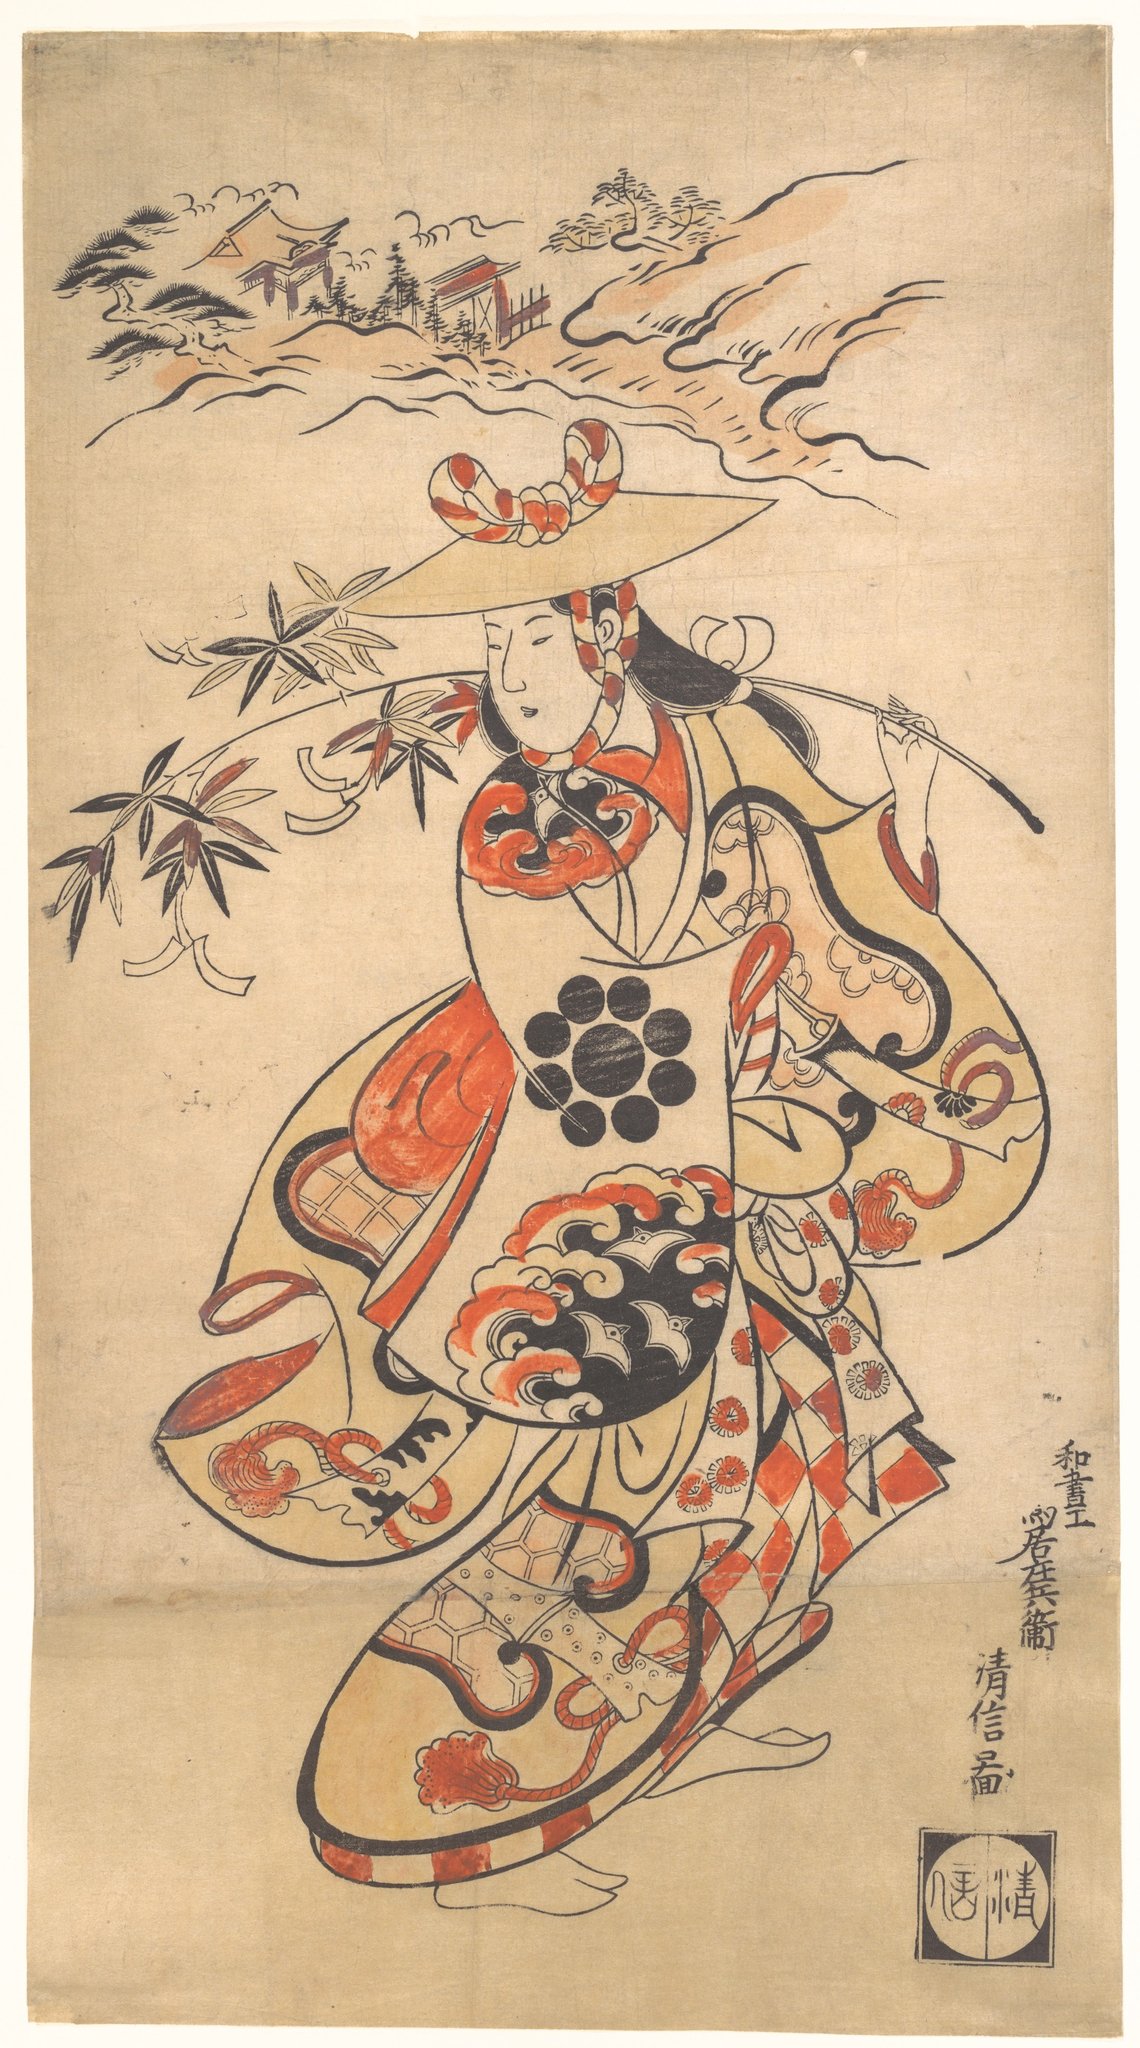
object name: print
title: Actor Sawamura Kodenji as a Woman at the Time of the Tanabata Festival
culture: japanese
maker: torii kiyonobu i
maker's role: artist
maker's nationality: japanese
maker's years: 1664-1729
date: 1698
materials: ink, paper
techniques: hand coloring, woodblock print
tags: women,leaves,actors